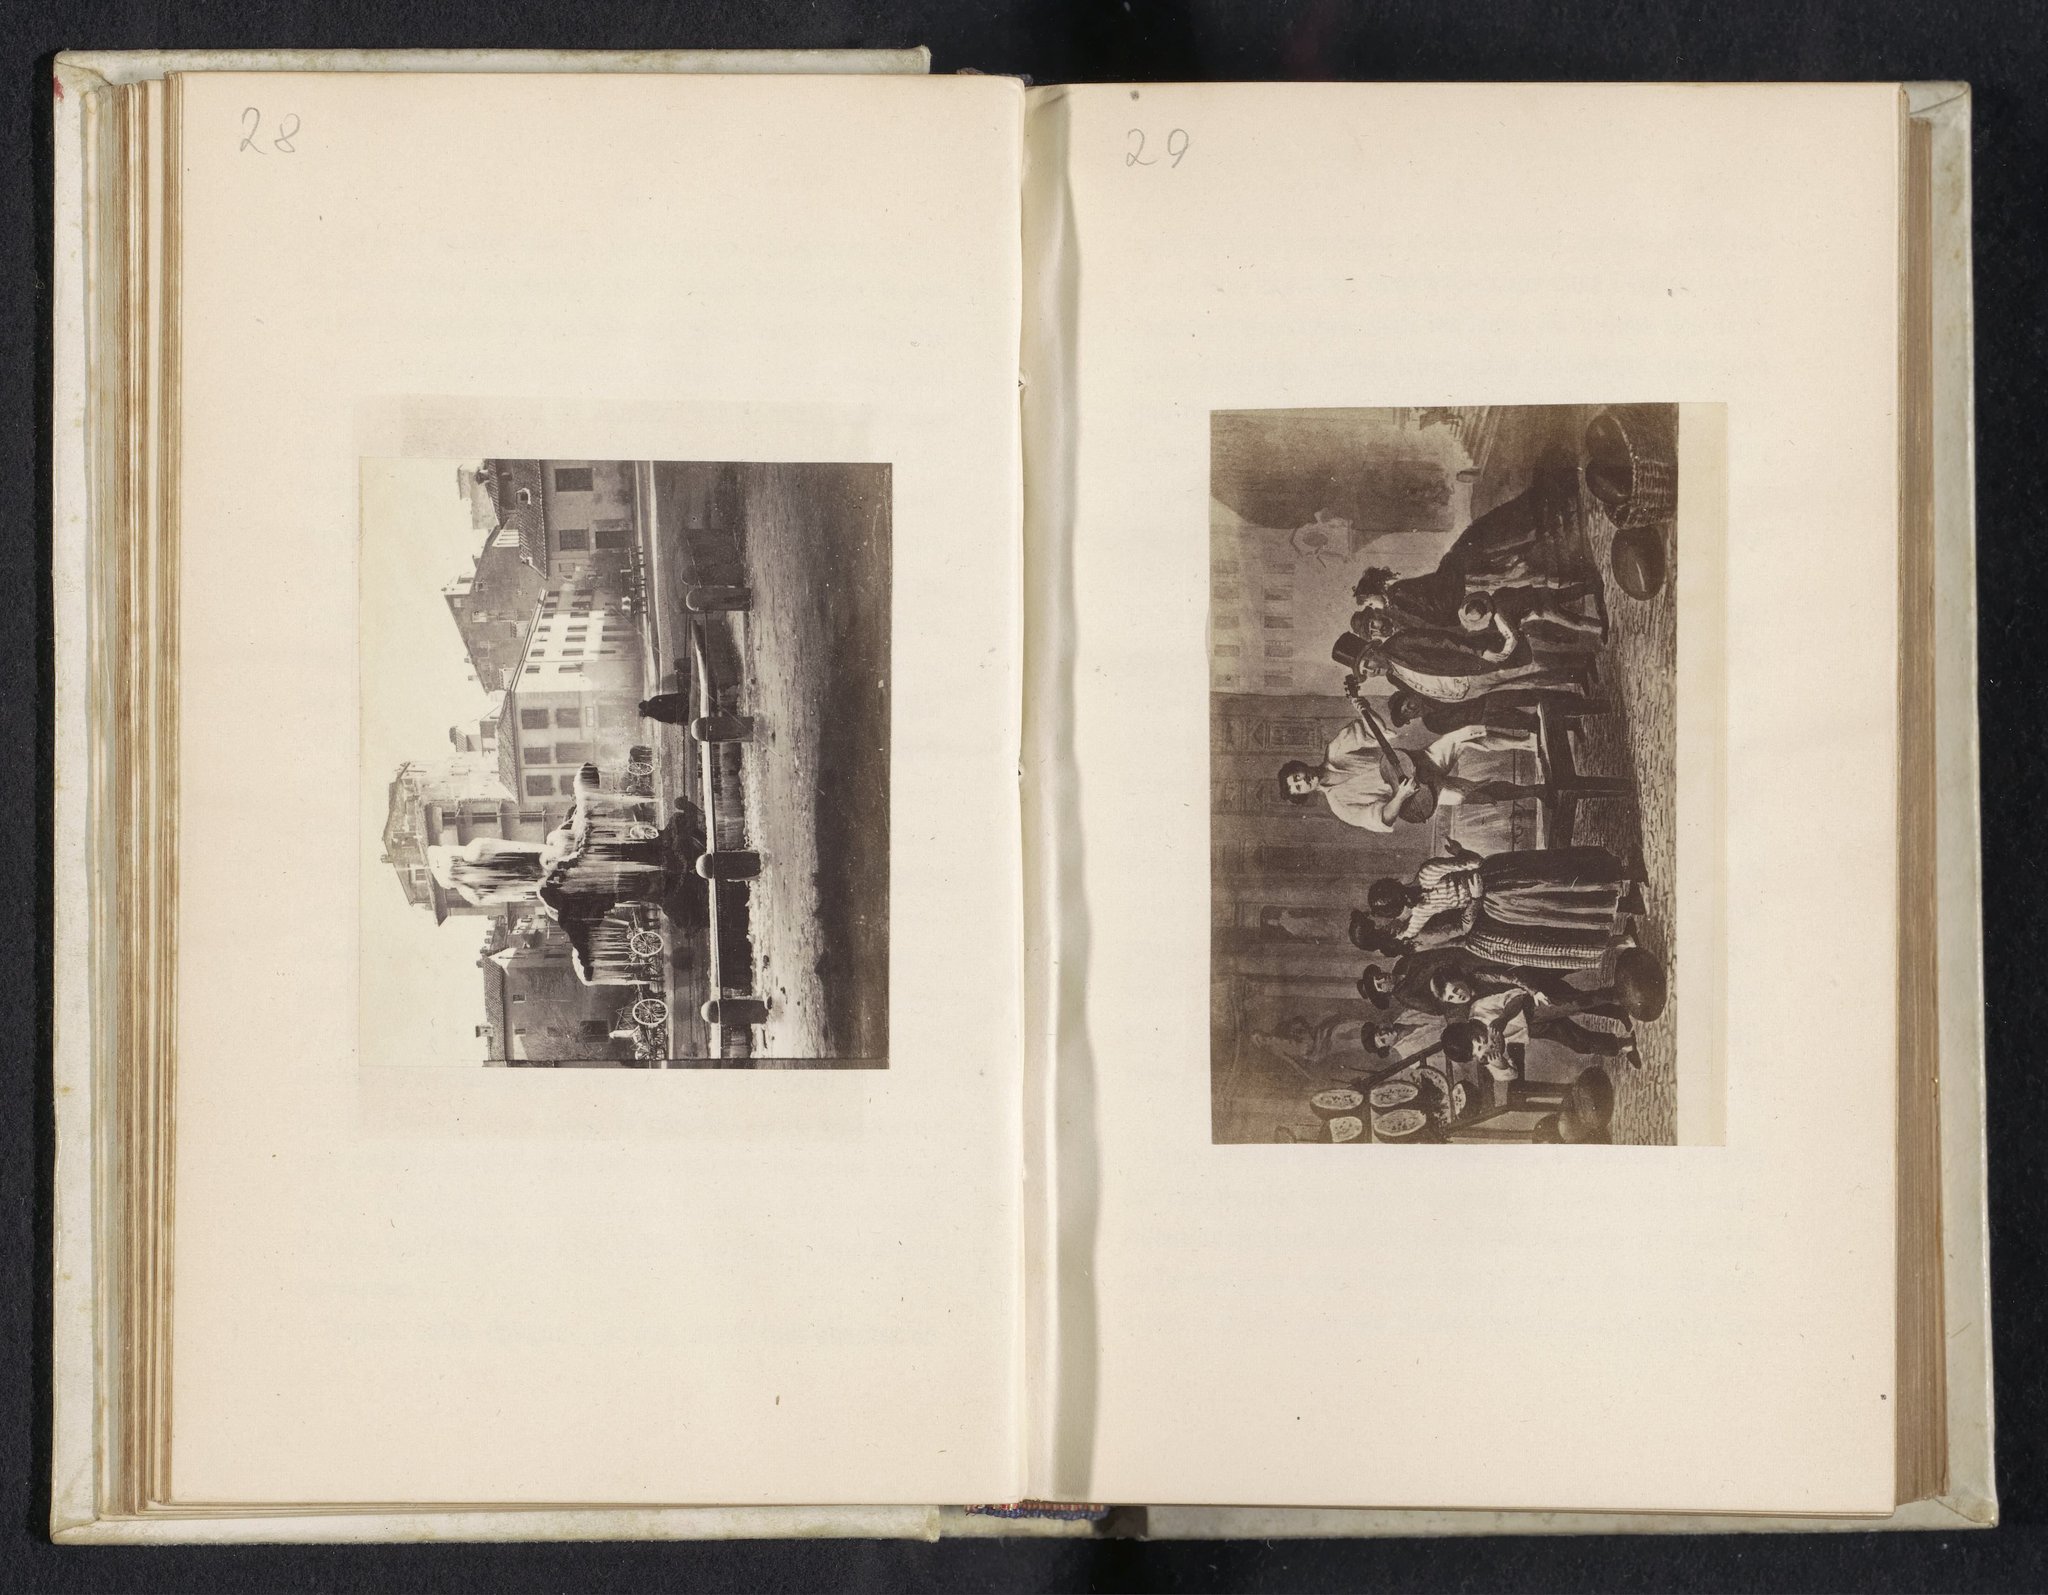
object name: photograph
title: Fotoreproductie van een schilderij, voorstellende een gitaarspelende man op een plein (vermoedelijk) te Rome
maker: Anonymous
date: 1850-1860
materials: photographic support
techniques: albumen print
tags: square, place, circus, etc., musician - cc - out of doors, cithern, mandolin, guitar, balalaika